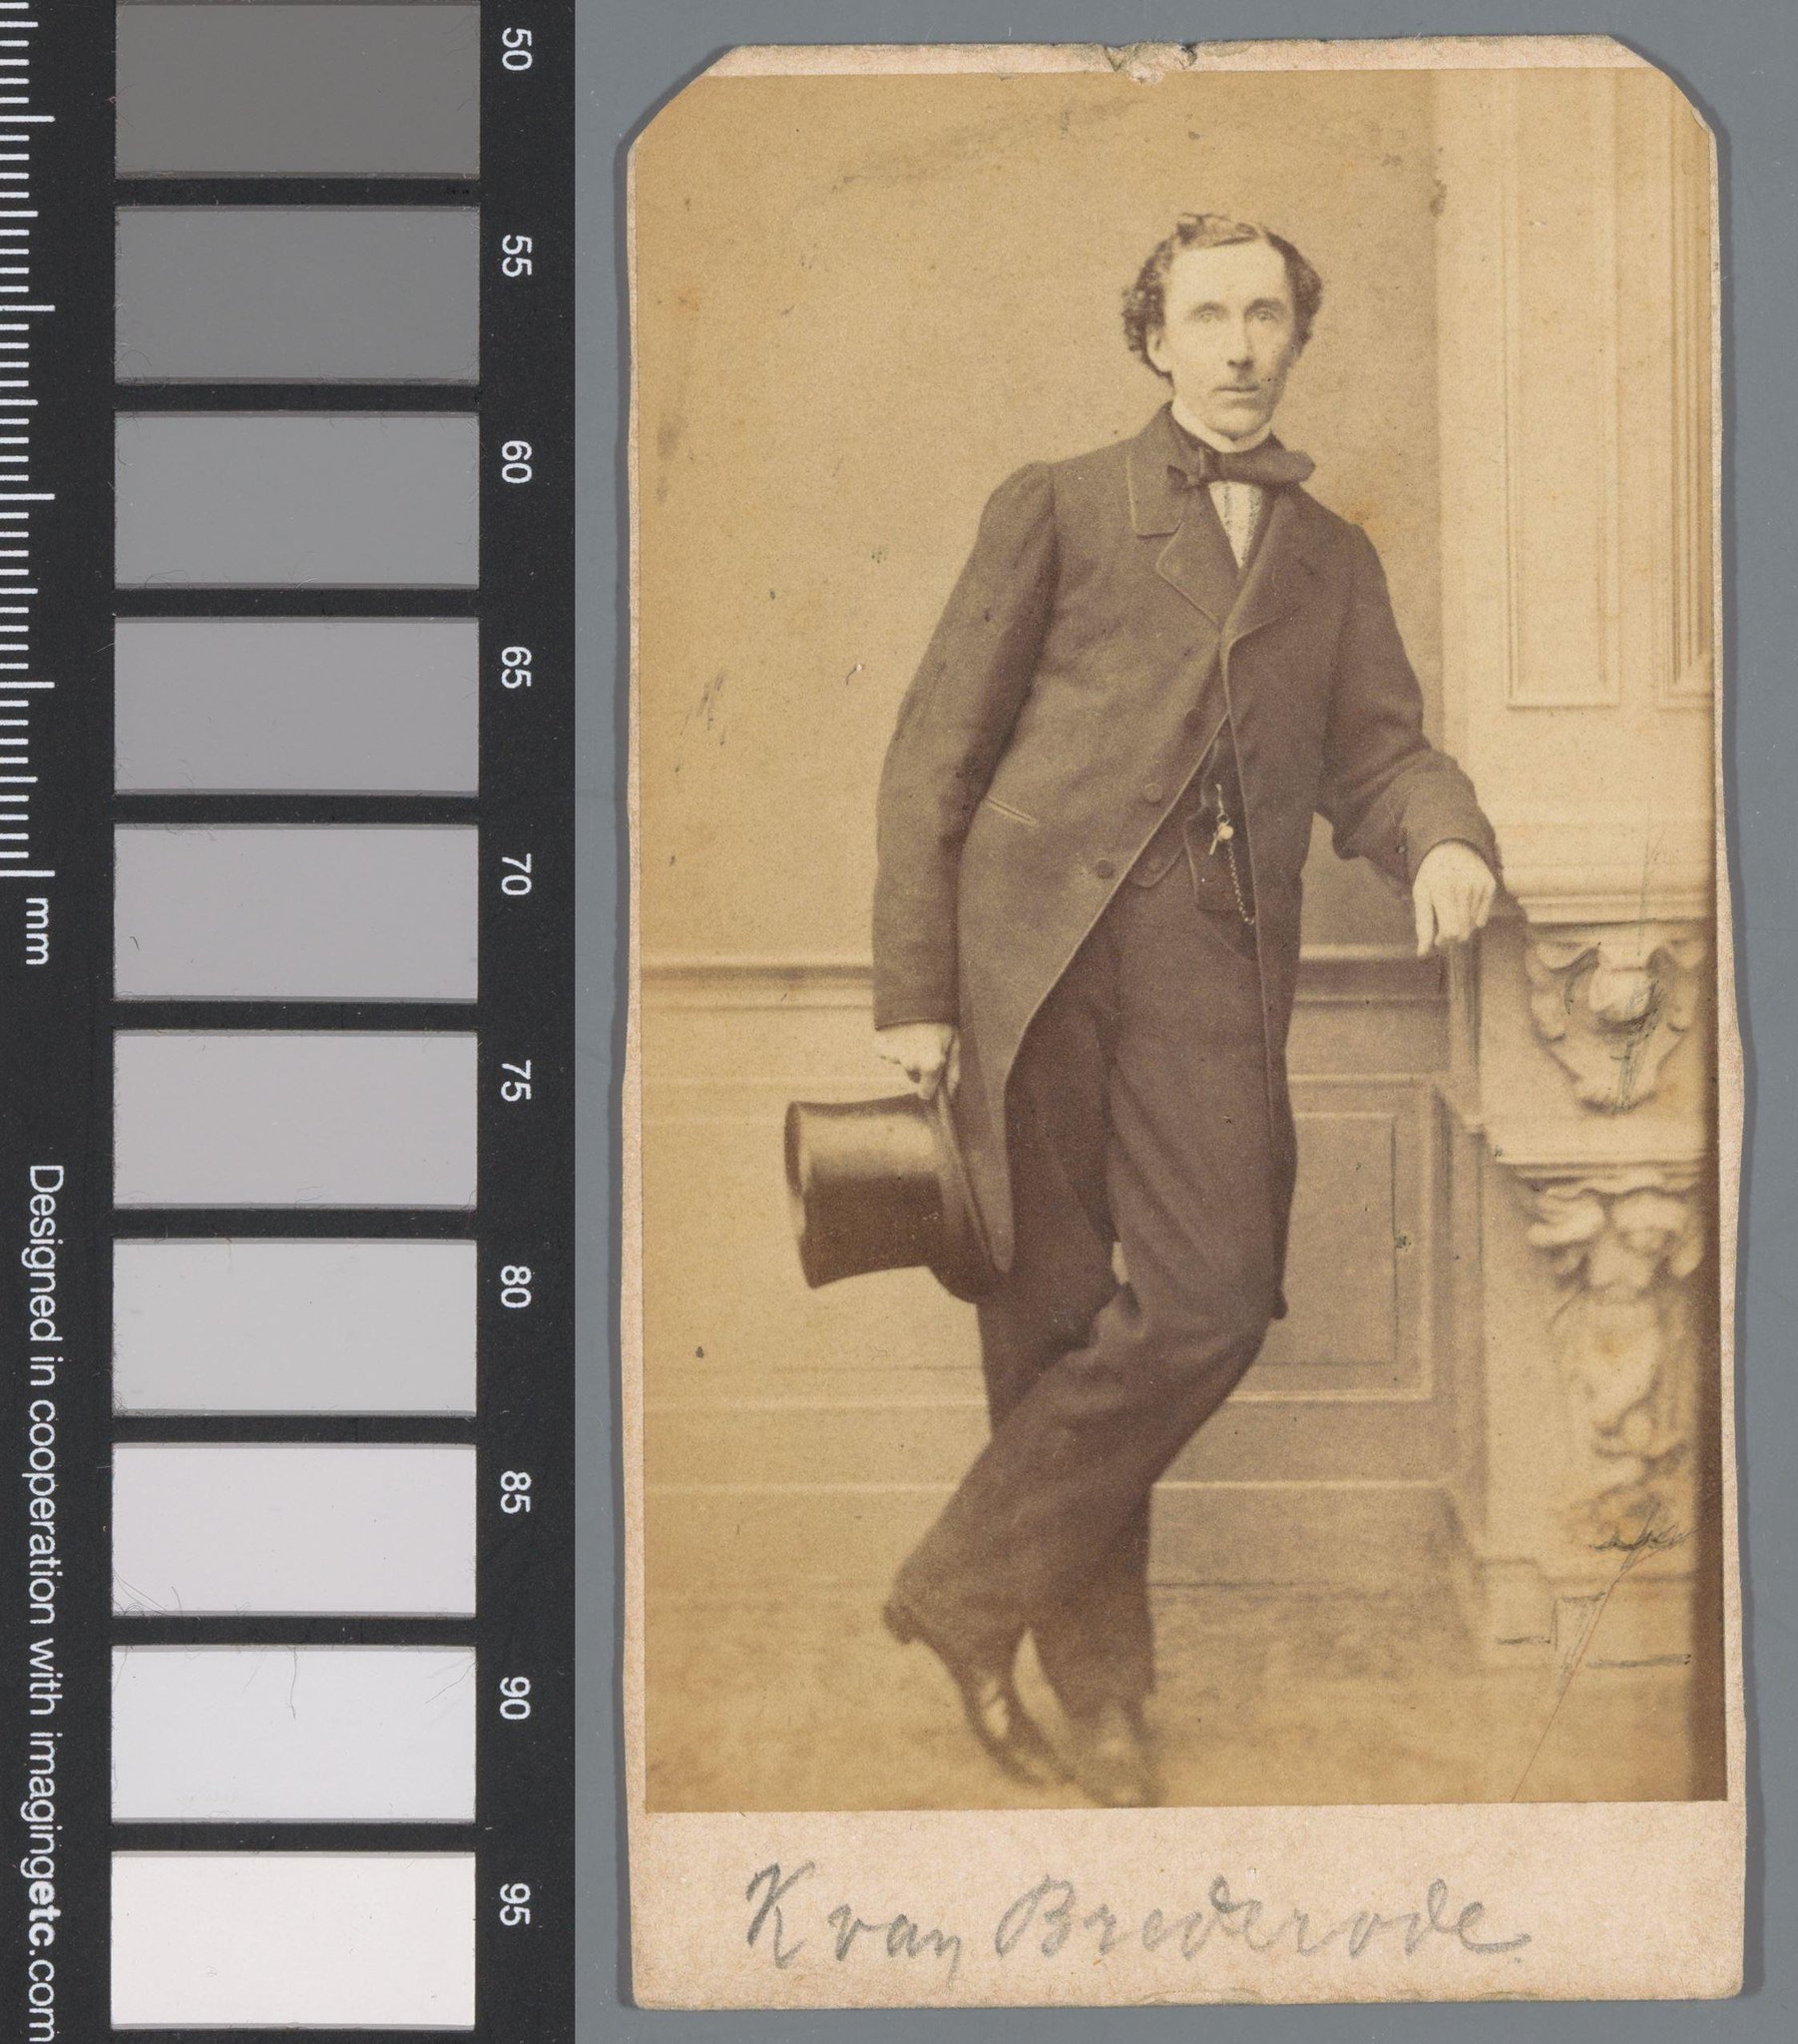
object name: photograph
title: Portret van Karel Hendrik van Brederode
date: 1858-1866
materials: cardboard, paper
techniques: albumen print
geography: the hague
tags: engineer, adult man, historical persons, the hague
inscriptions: inscription: ‘Polman & Hohmann,/ Willemstraat, 59,/ 's Gravenhage.’, inscription: ‘K. van Brederode’